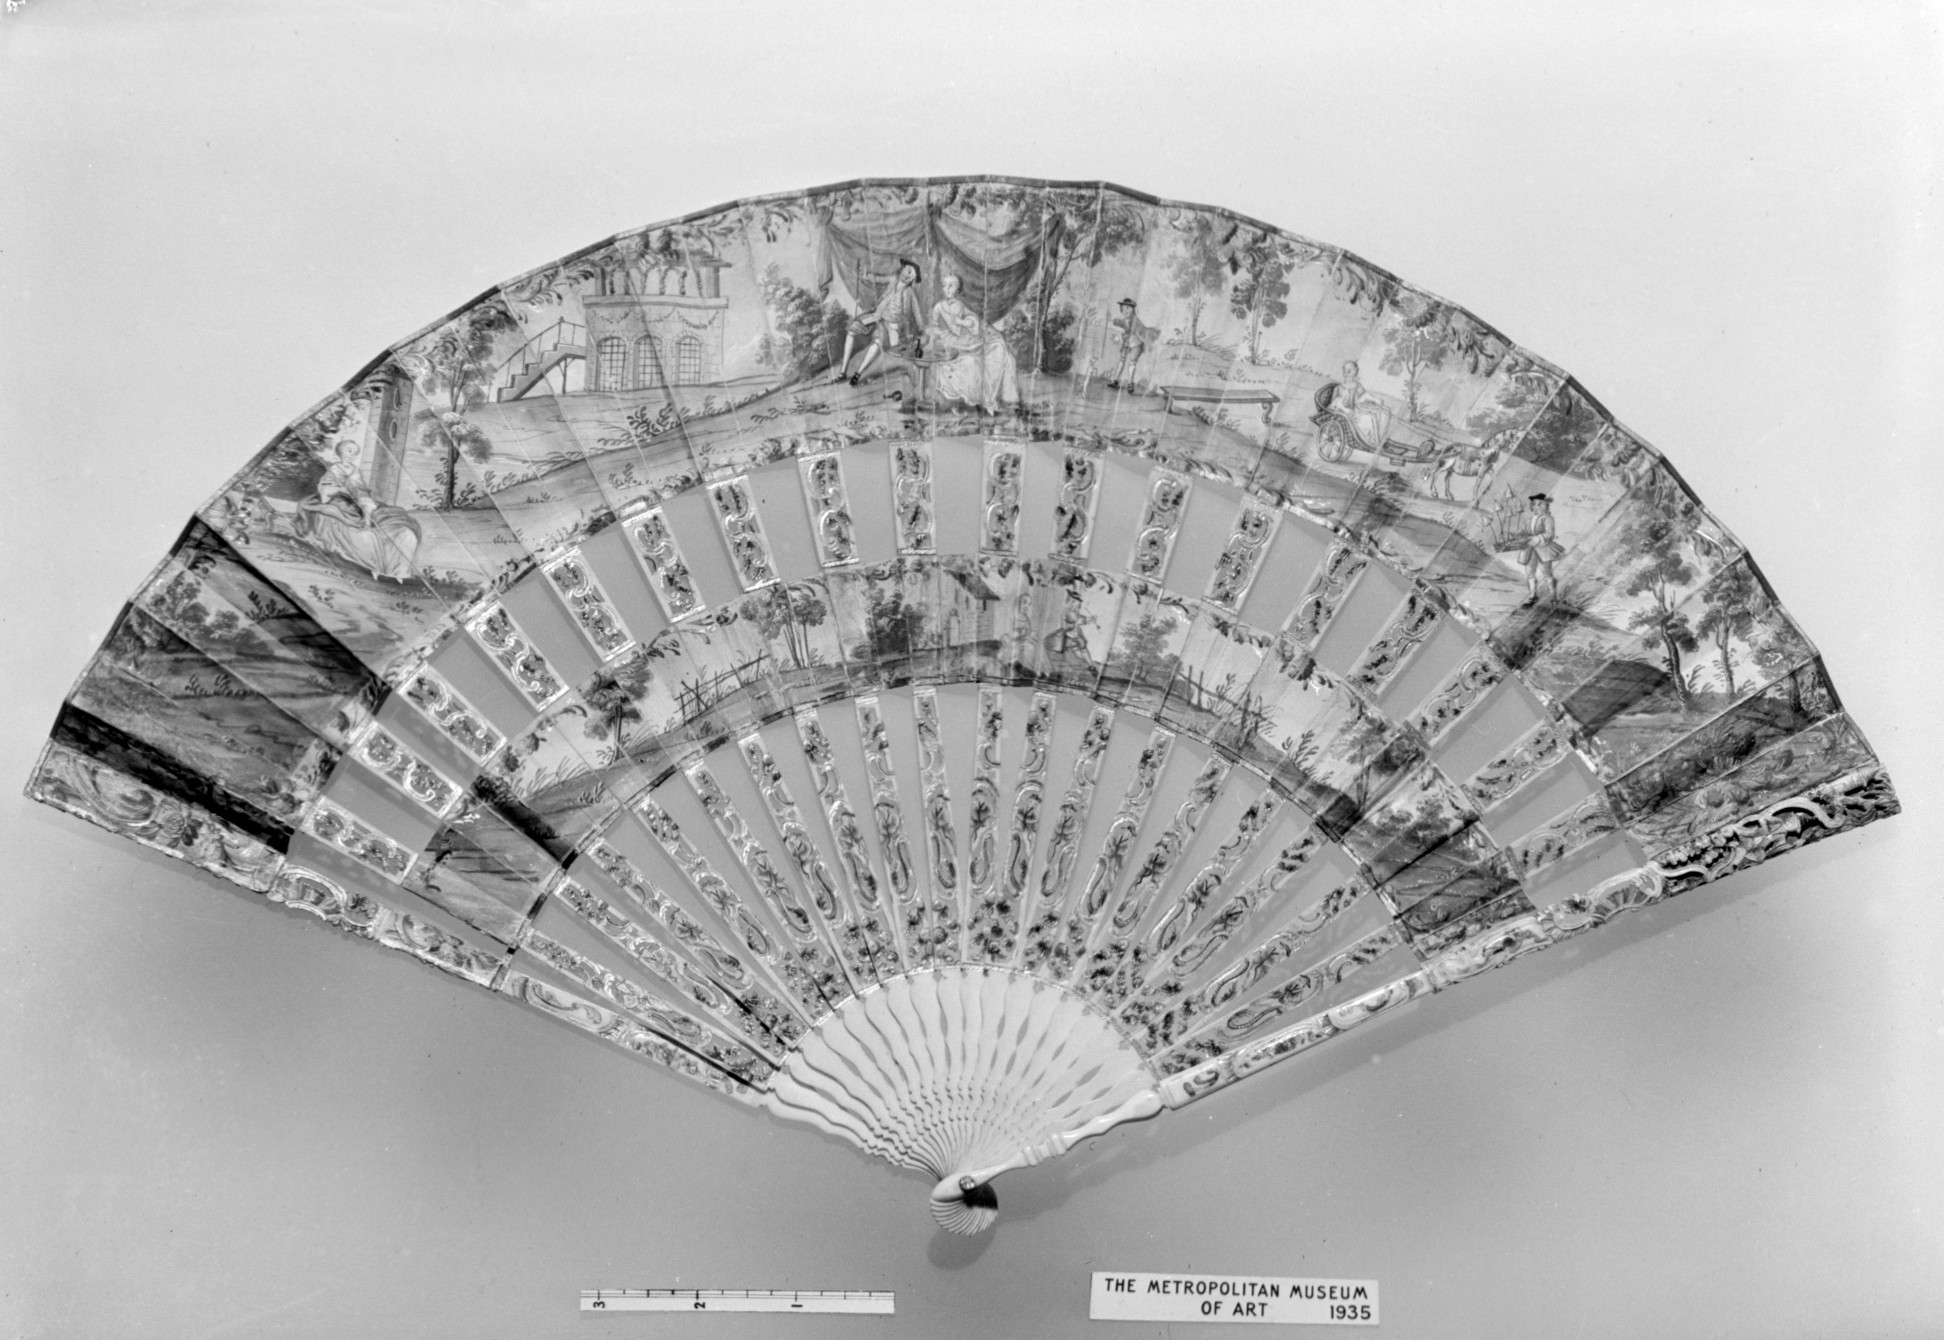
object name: fan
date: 1751-1775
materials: ivory, paint, paper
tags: men,women,landscapes,chariots